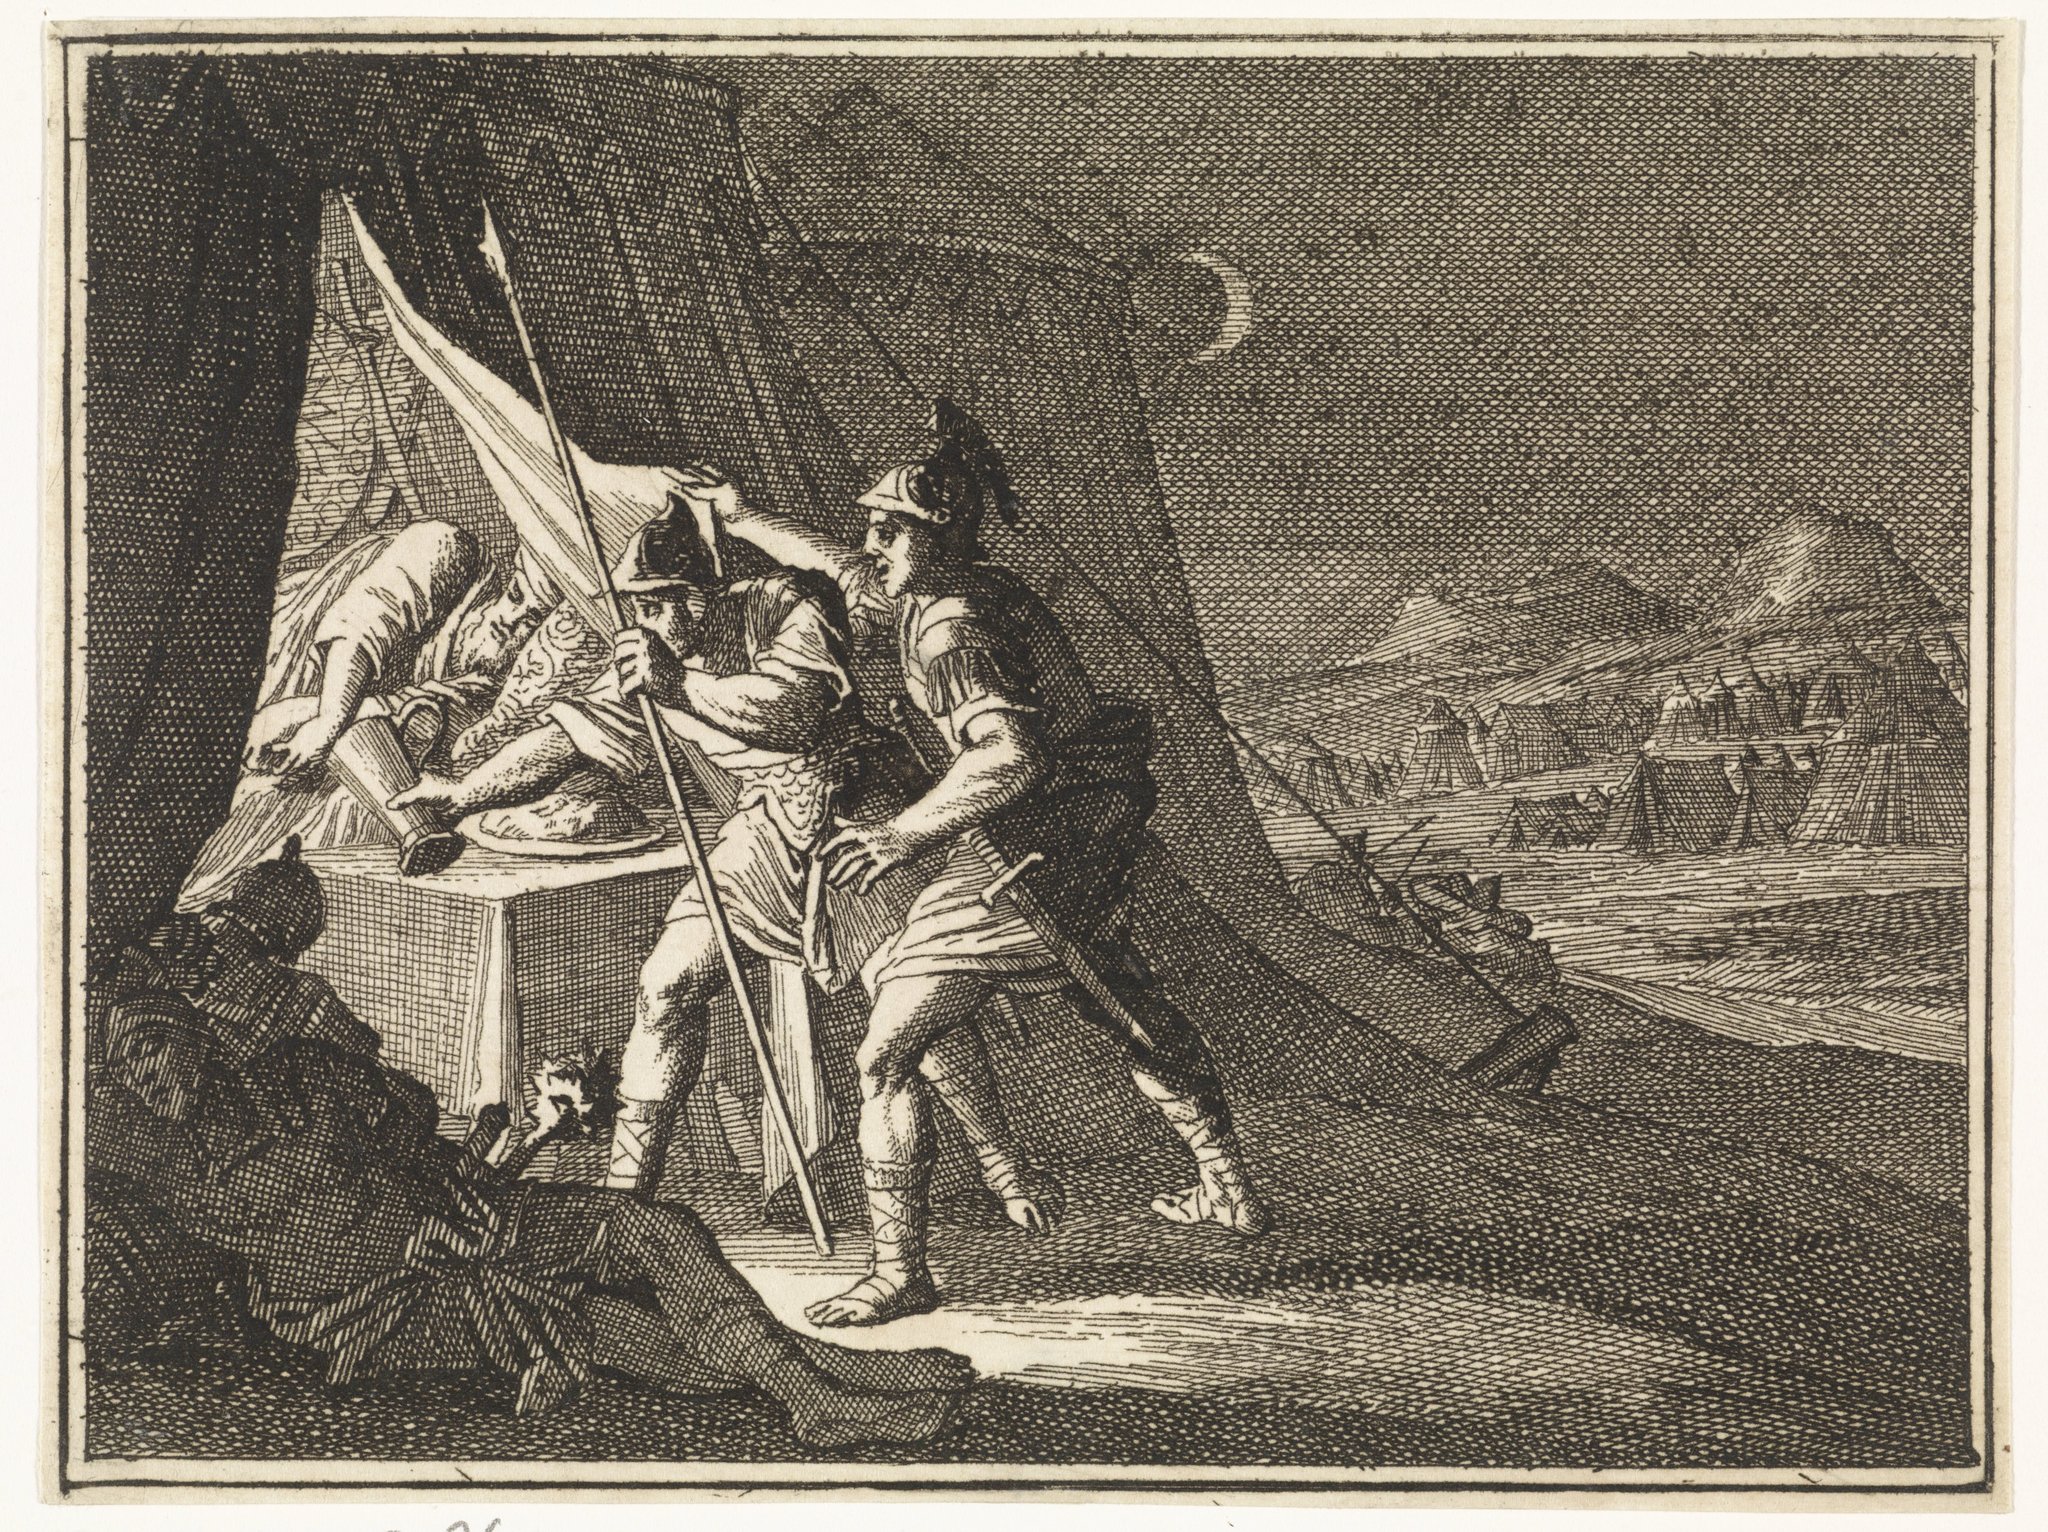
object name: print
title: David neemt de speer en beker van Saul weg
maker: caspar luyken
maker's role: draughtsman, print maker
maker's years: 1672-1708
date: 1712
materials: paper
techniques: etching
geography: amsterdam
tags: david takes saul's spear and water-flask away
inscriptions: number: ‘109’, collector's mark: Lugt 2228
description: Illustratie uit: Luyken, Jan. De schriftuurlyke geschiedenissen en gelykenissen van het Oude en Nieuwe Verbond, 2 delen. Amsterdam: Wed. Pieter Arentsz II en Cornelis van der Sys, 1712, dl. I.